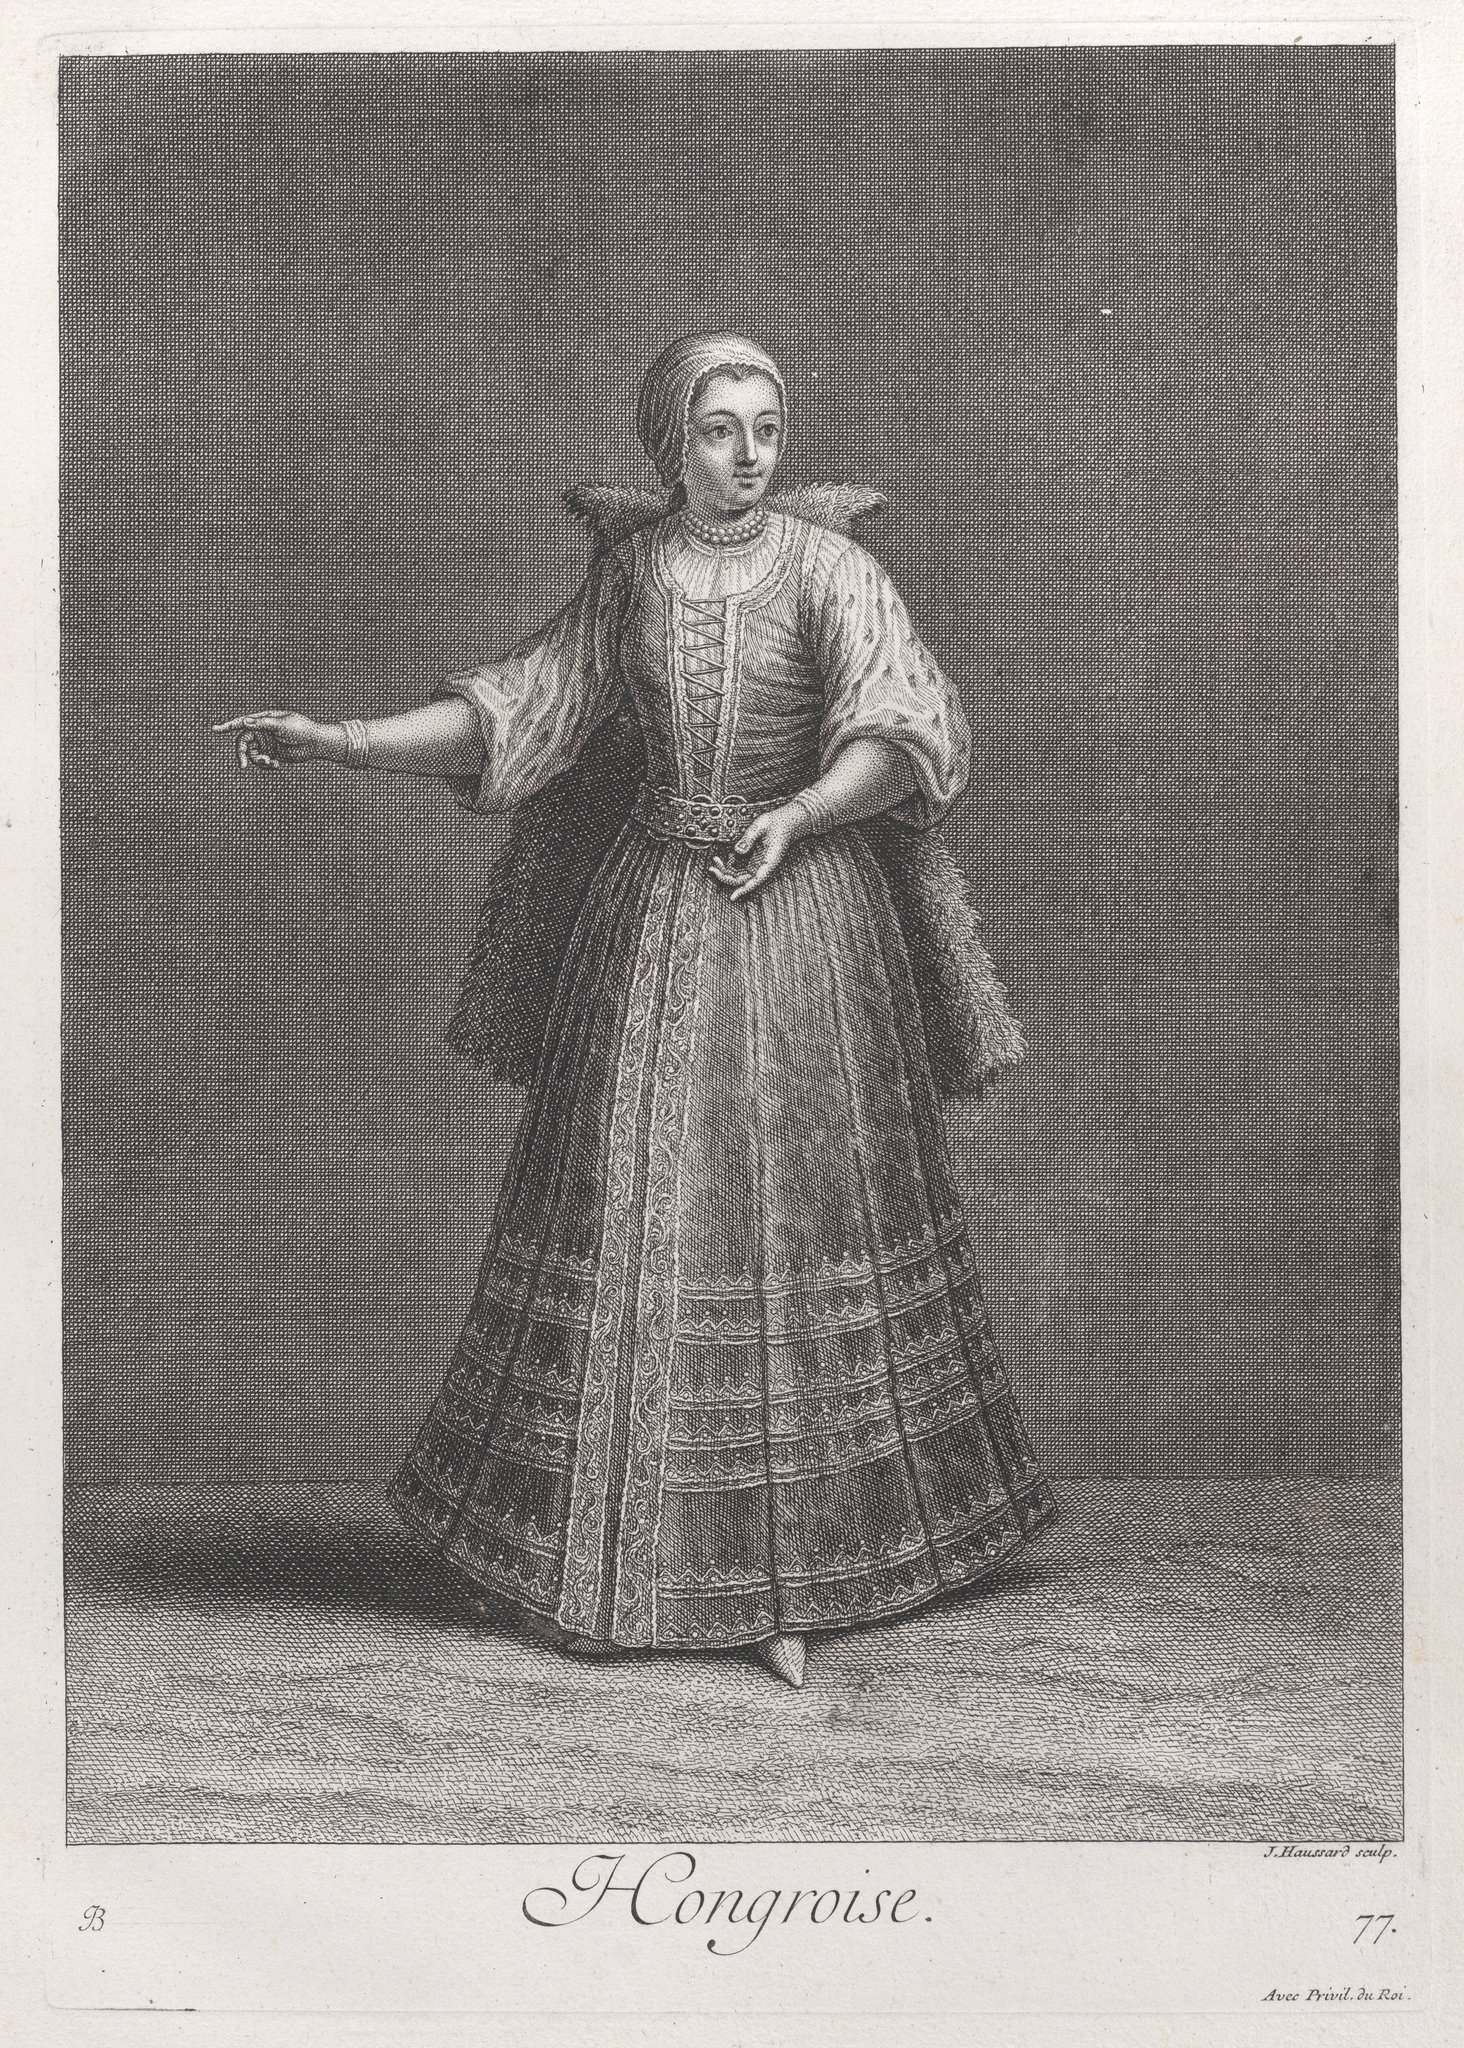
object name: print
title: Hongroise, plate 77 from "Recueil de cent estampes représentent differentes nations du Levant"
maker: jean baptiste vanmour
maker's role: artist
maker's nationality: french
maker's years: 1671-1737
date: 1714-1715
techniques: engraving, etching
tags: women